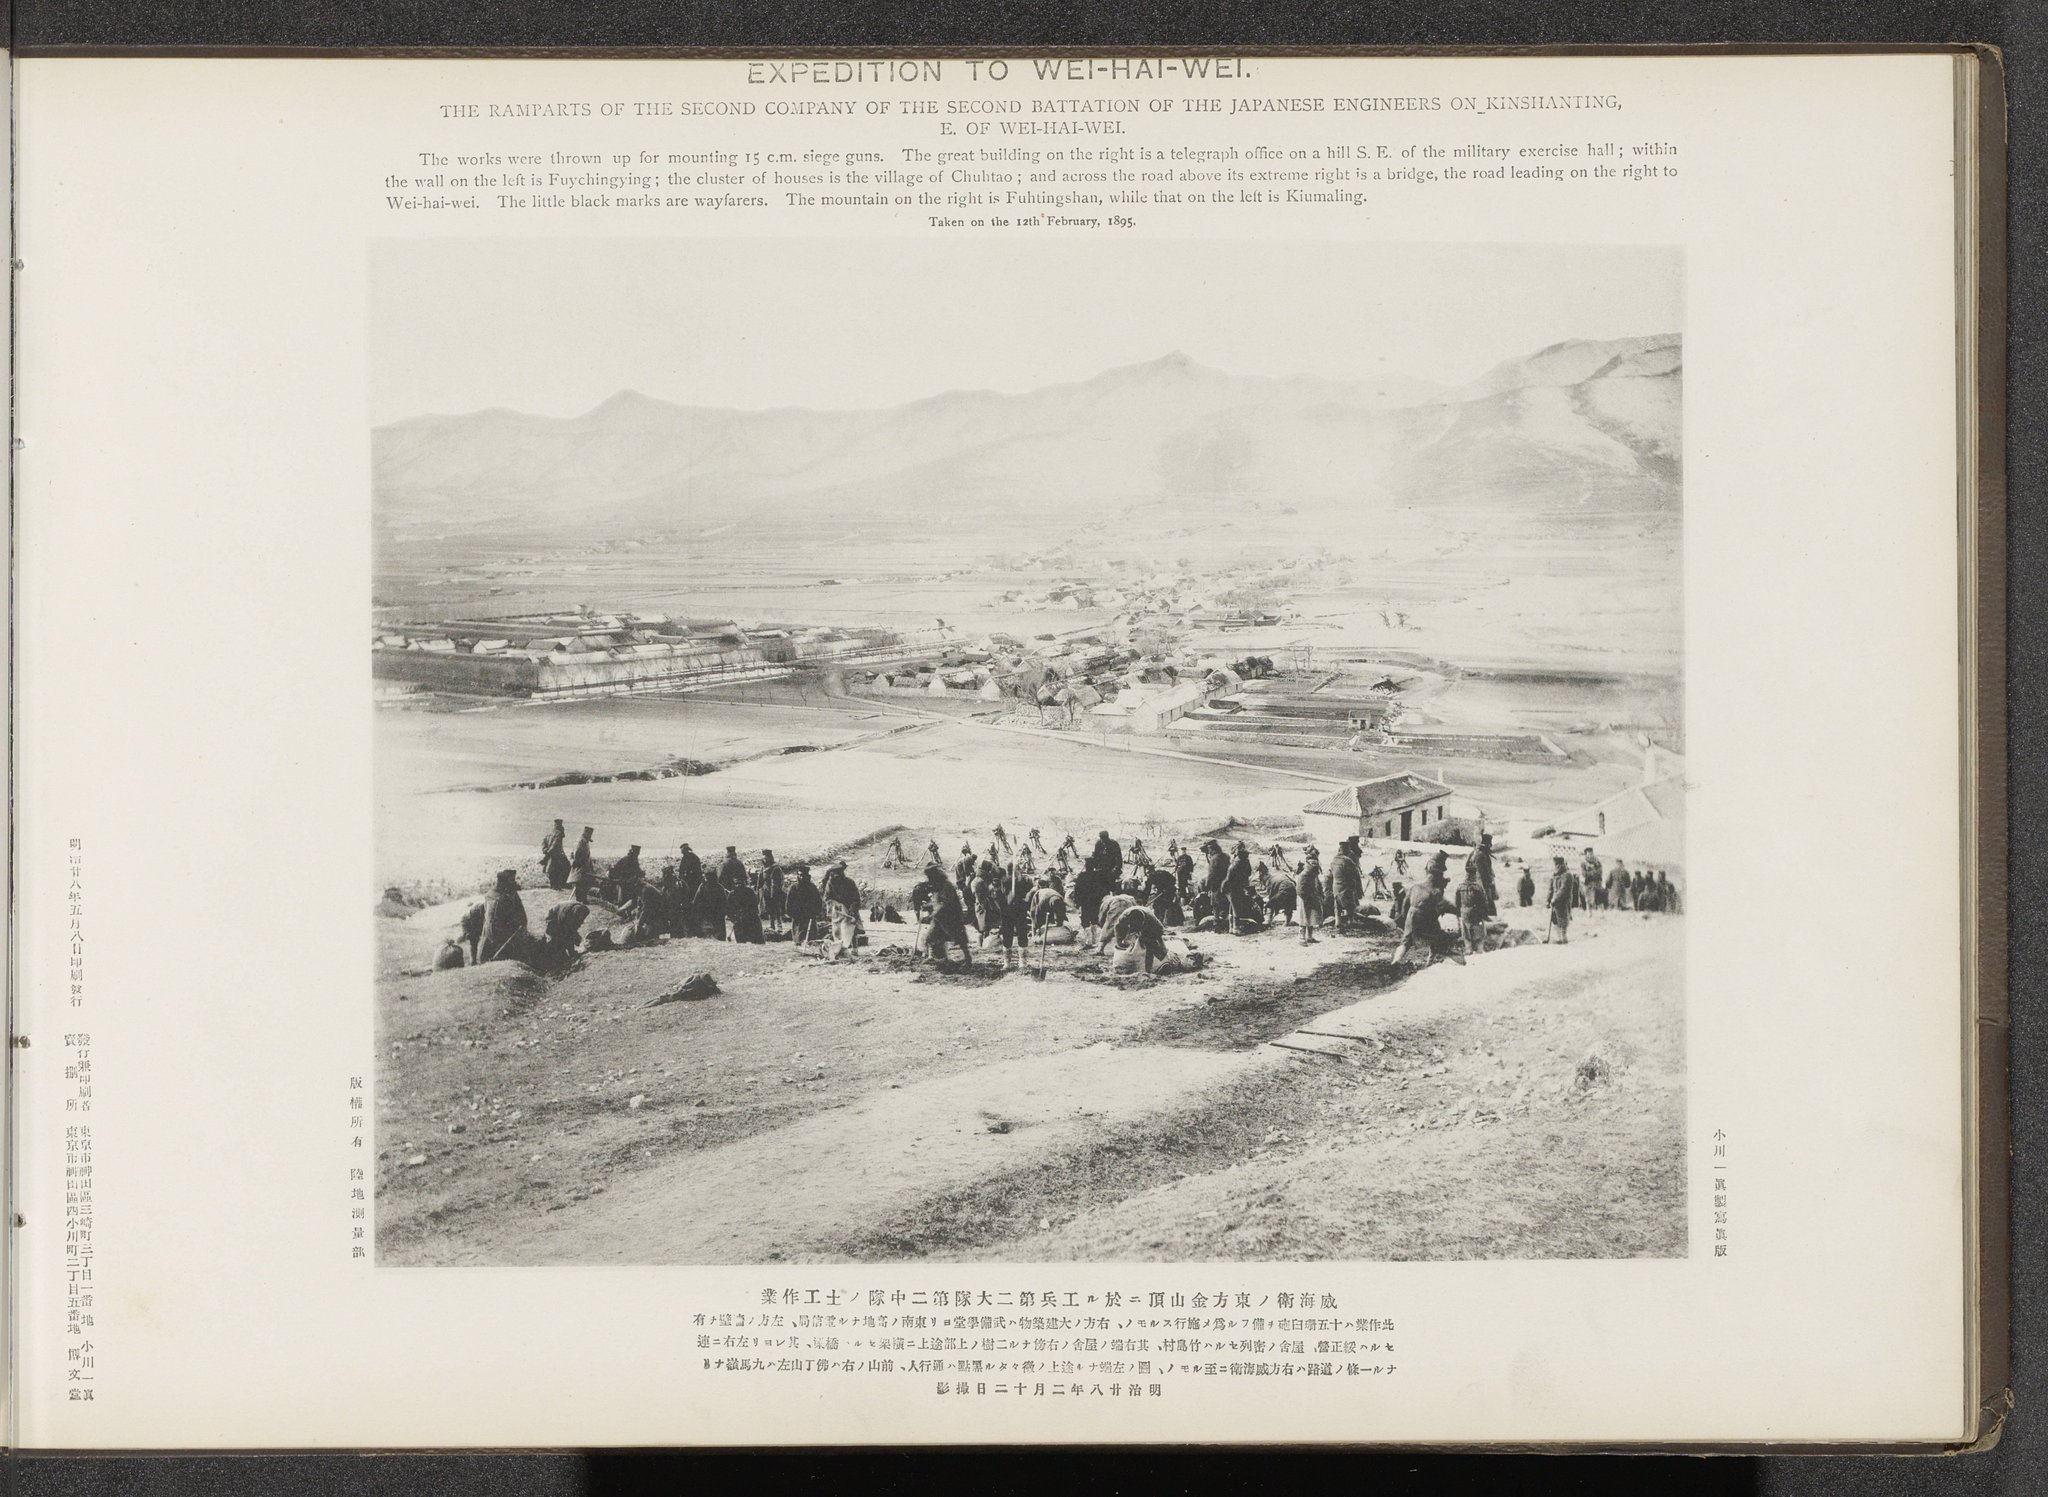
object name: photomechanical print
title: The ramparts of the second compagny of the second battation of the Japanese engineers on Kinshanting, E. of Wei-Hai-Wei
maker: kazumasa ogawa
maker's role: auteur, fotograaf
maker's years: 1860-1929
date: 1895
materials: paper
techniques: photograph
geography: shandong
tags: low hill country, engineering, warfare; military affairs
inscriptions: inscription: ‘The works were thrown up for mounting (...) while that on the left is Kiumaling.’, inscription: ‘Expedition to Wei-Hai-Wei.’